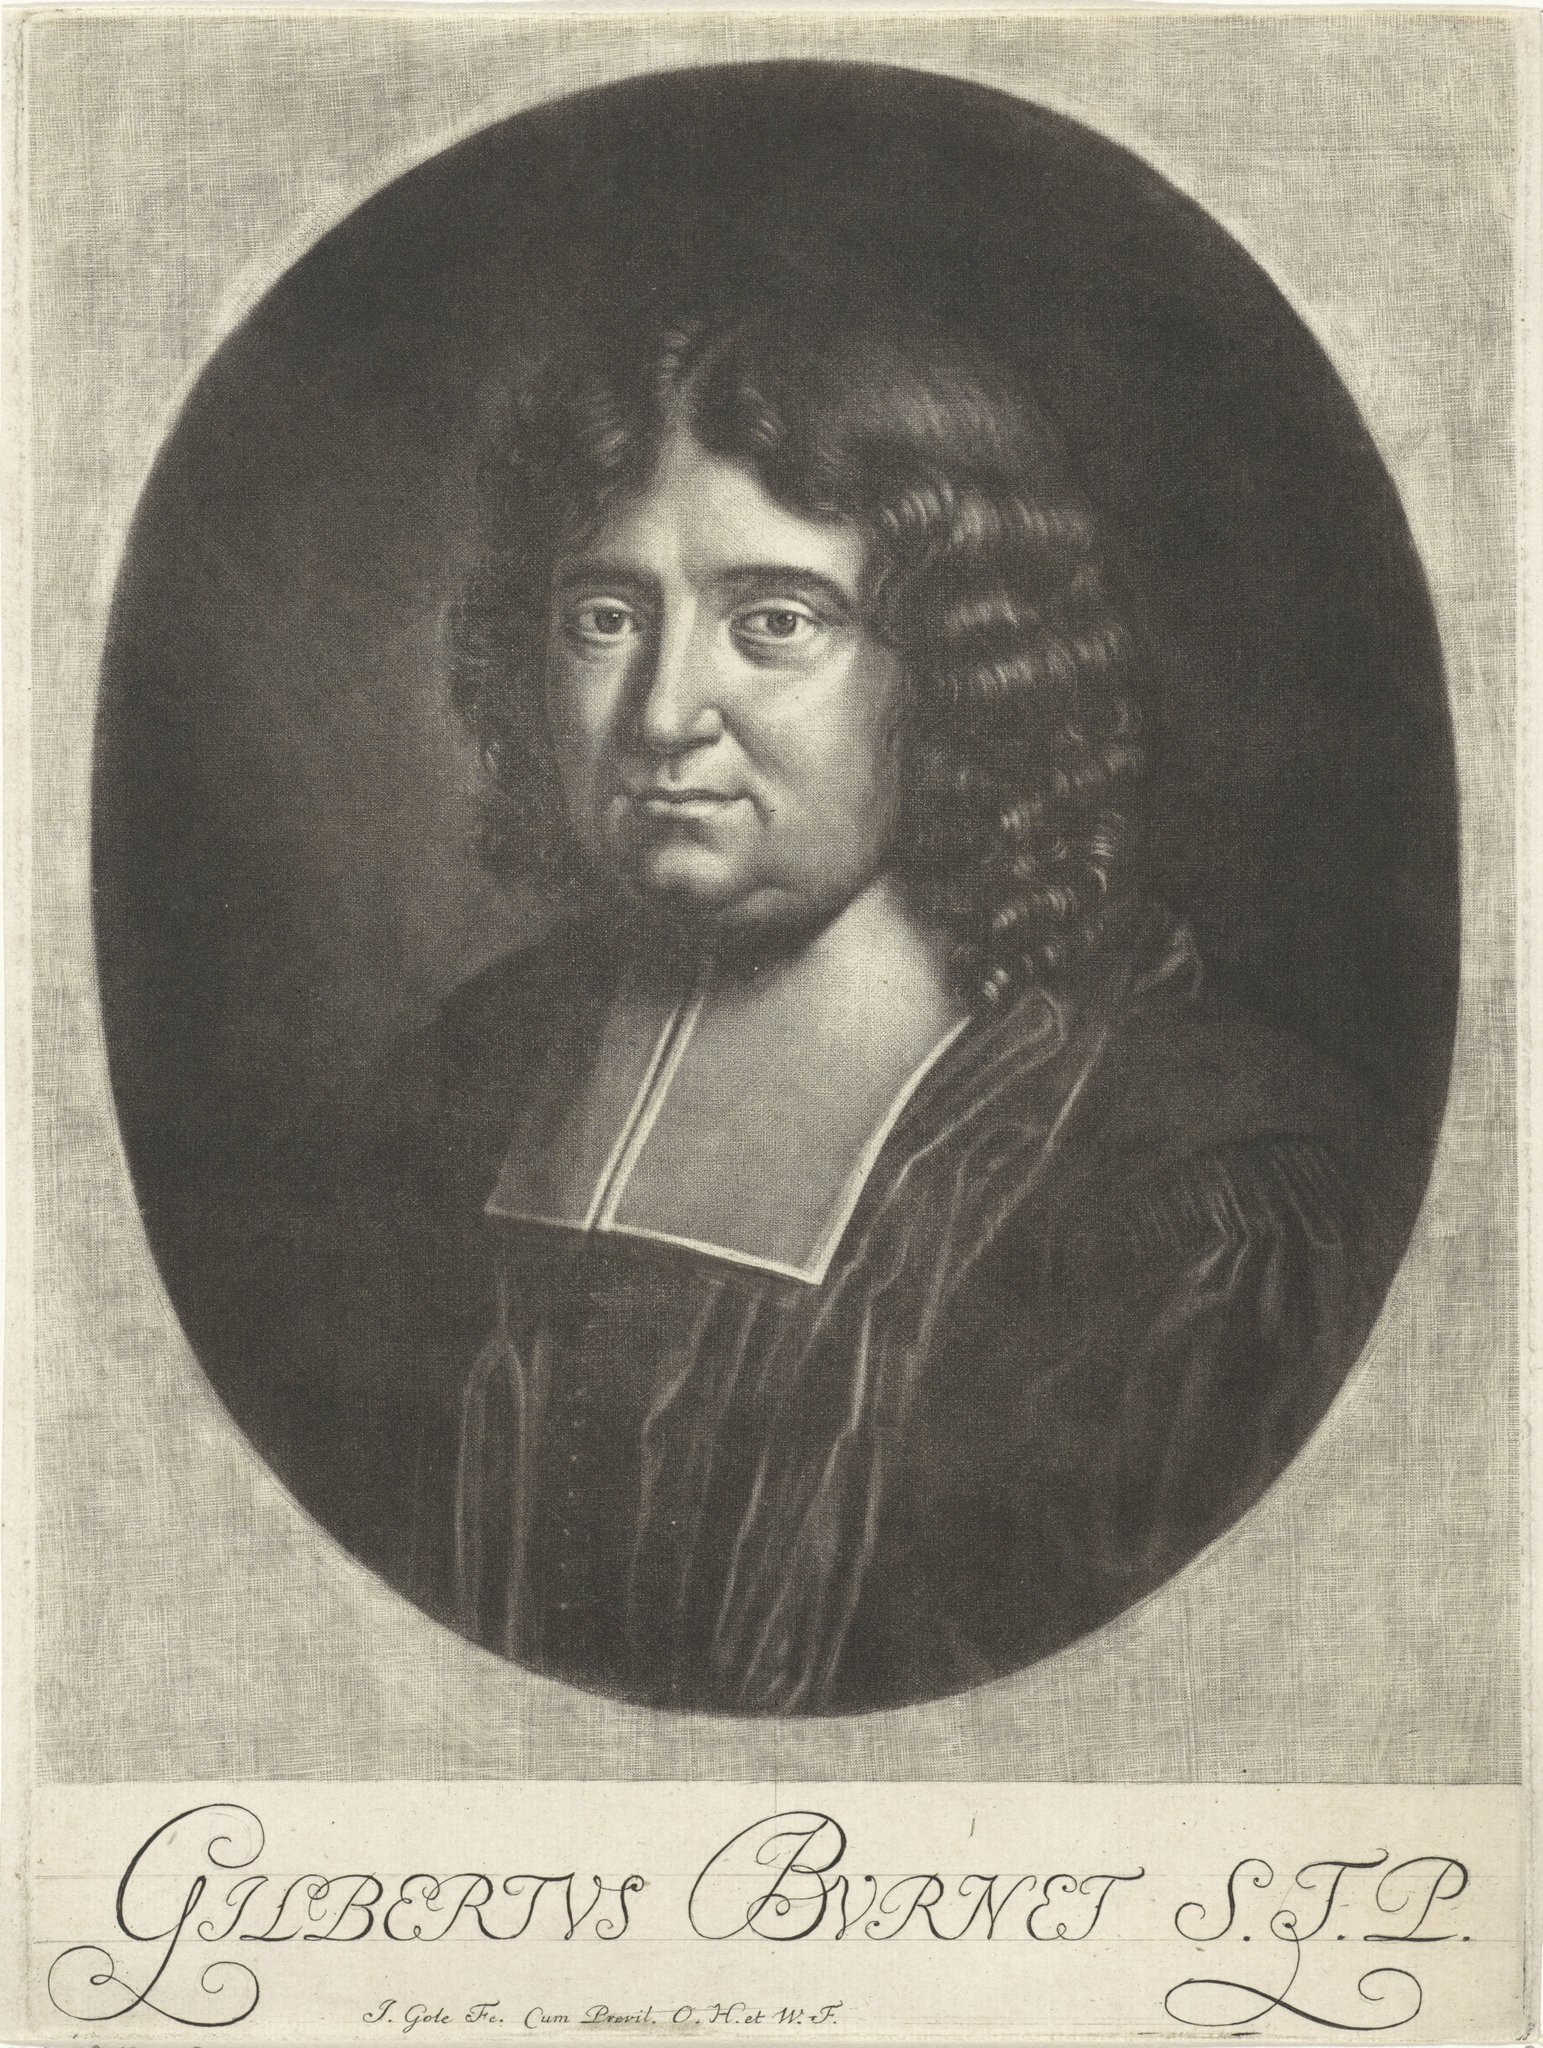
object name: print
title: Portret van Gilbert Burnet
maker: jacob gole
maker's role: print maker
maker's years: 1660-1724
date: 1670-1724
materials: paper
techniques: engraving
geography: amsterdam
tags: bisschop, gilbert burnet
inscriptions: collector's mark: Lugt 2228